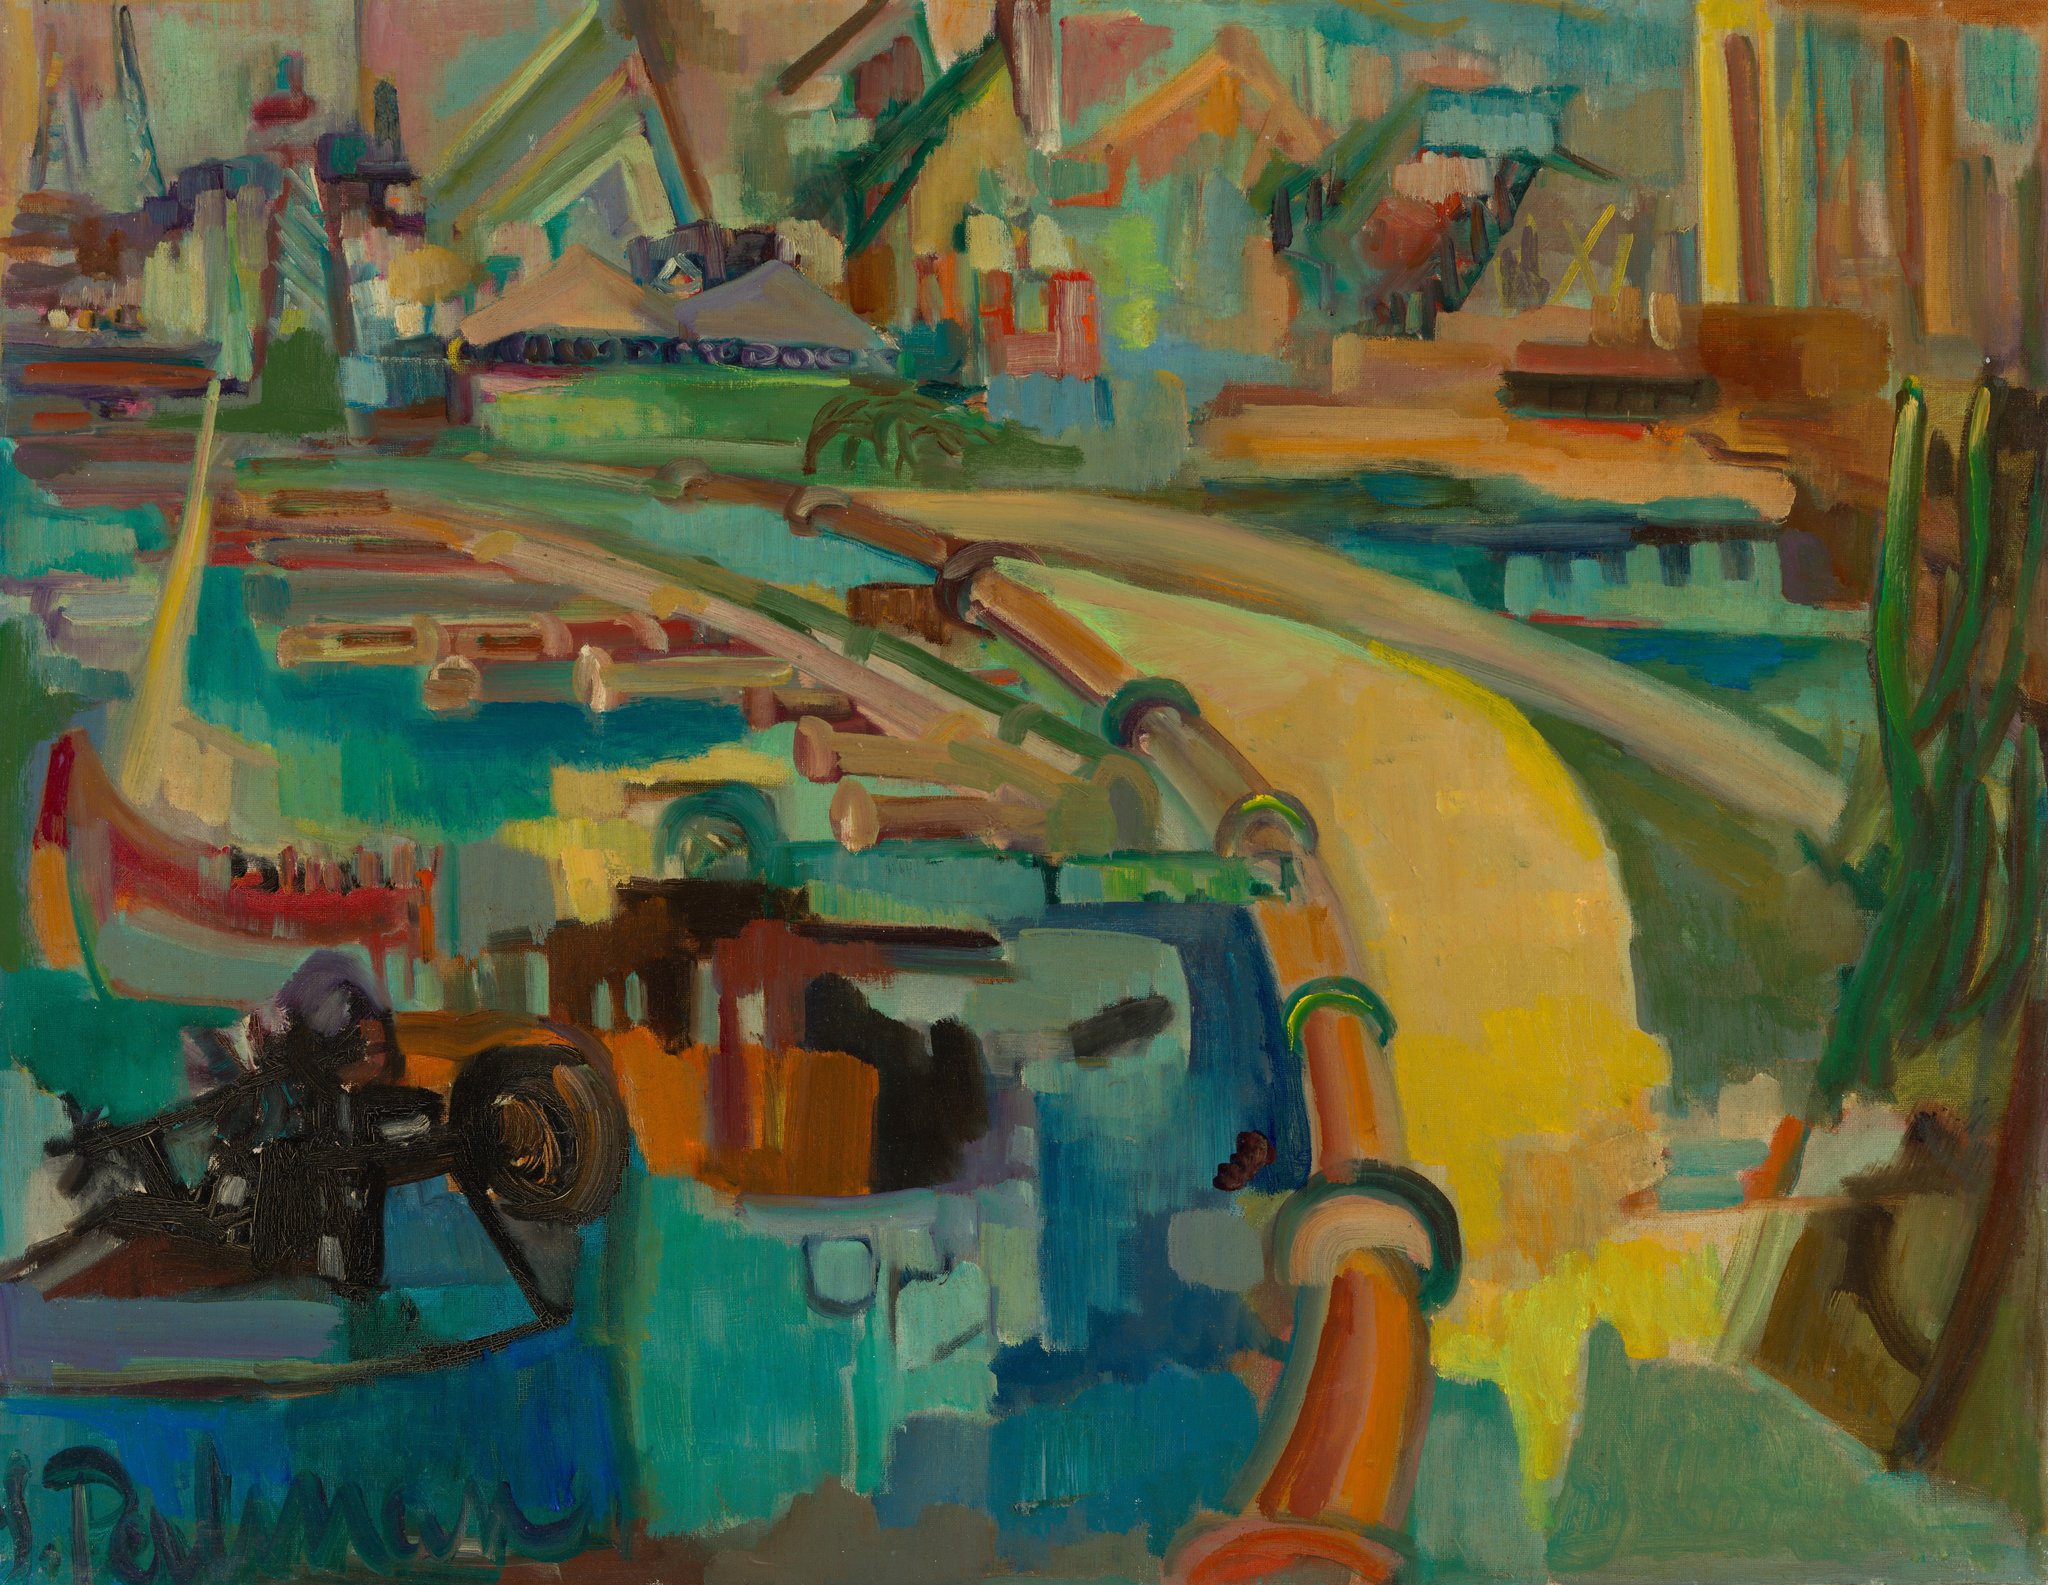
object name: painting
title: Dry Dock on Curaçao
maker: suzanne perlman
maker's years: 1922-2020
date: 1959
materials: canvas, oil, paint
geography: curacao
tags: pipeline ~transportation of oil, dry-dock, floating-dock, plants and herbs: cactus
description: The industrial scaling up that gripped the post-war Netherlands also took place in the Caribbean Netherlands. The oil refinery of Shell, the British-Dutch company on Curaçao, is the subject of this painting: an industrial landscape with pipelines, cranes and ships. The cactus on the right identifies the landscape as Antillean.